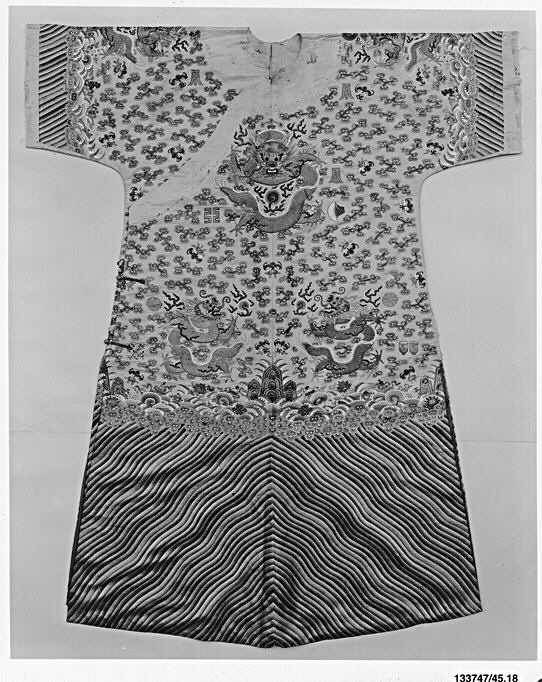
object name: robe, emperor's 12 symbol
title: Emperor's Twelve-Symbol Robe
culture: chinese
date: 1821-1850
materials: metal thread, silk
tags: dragons